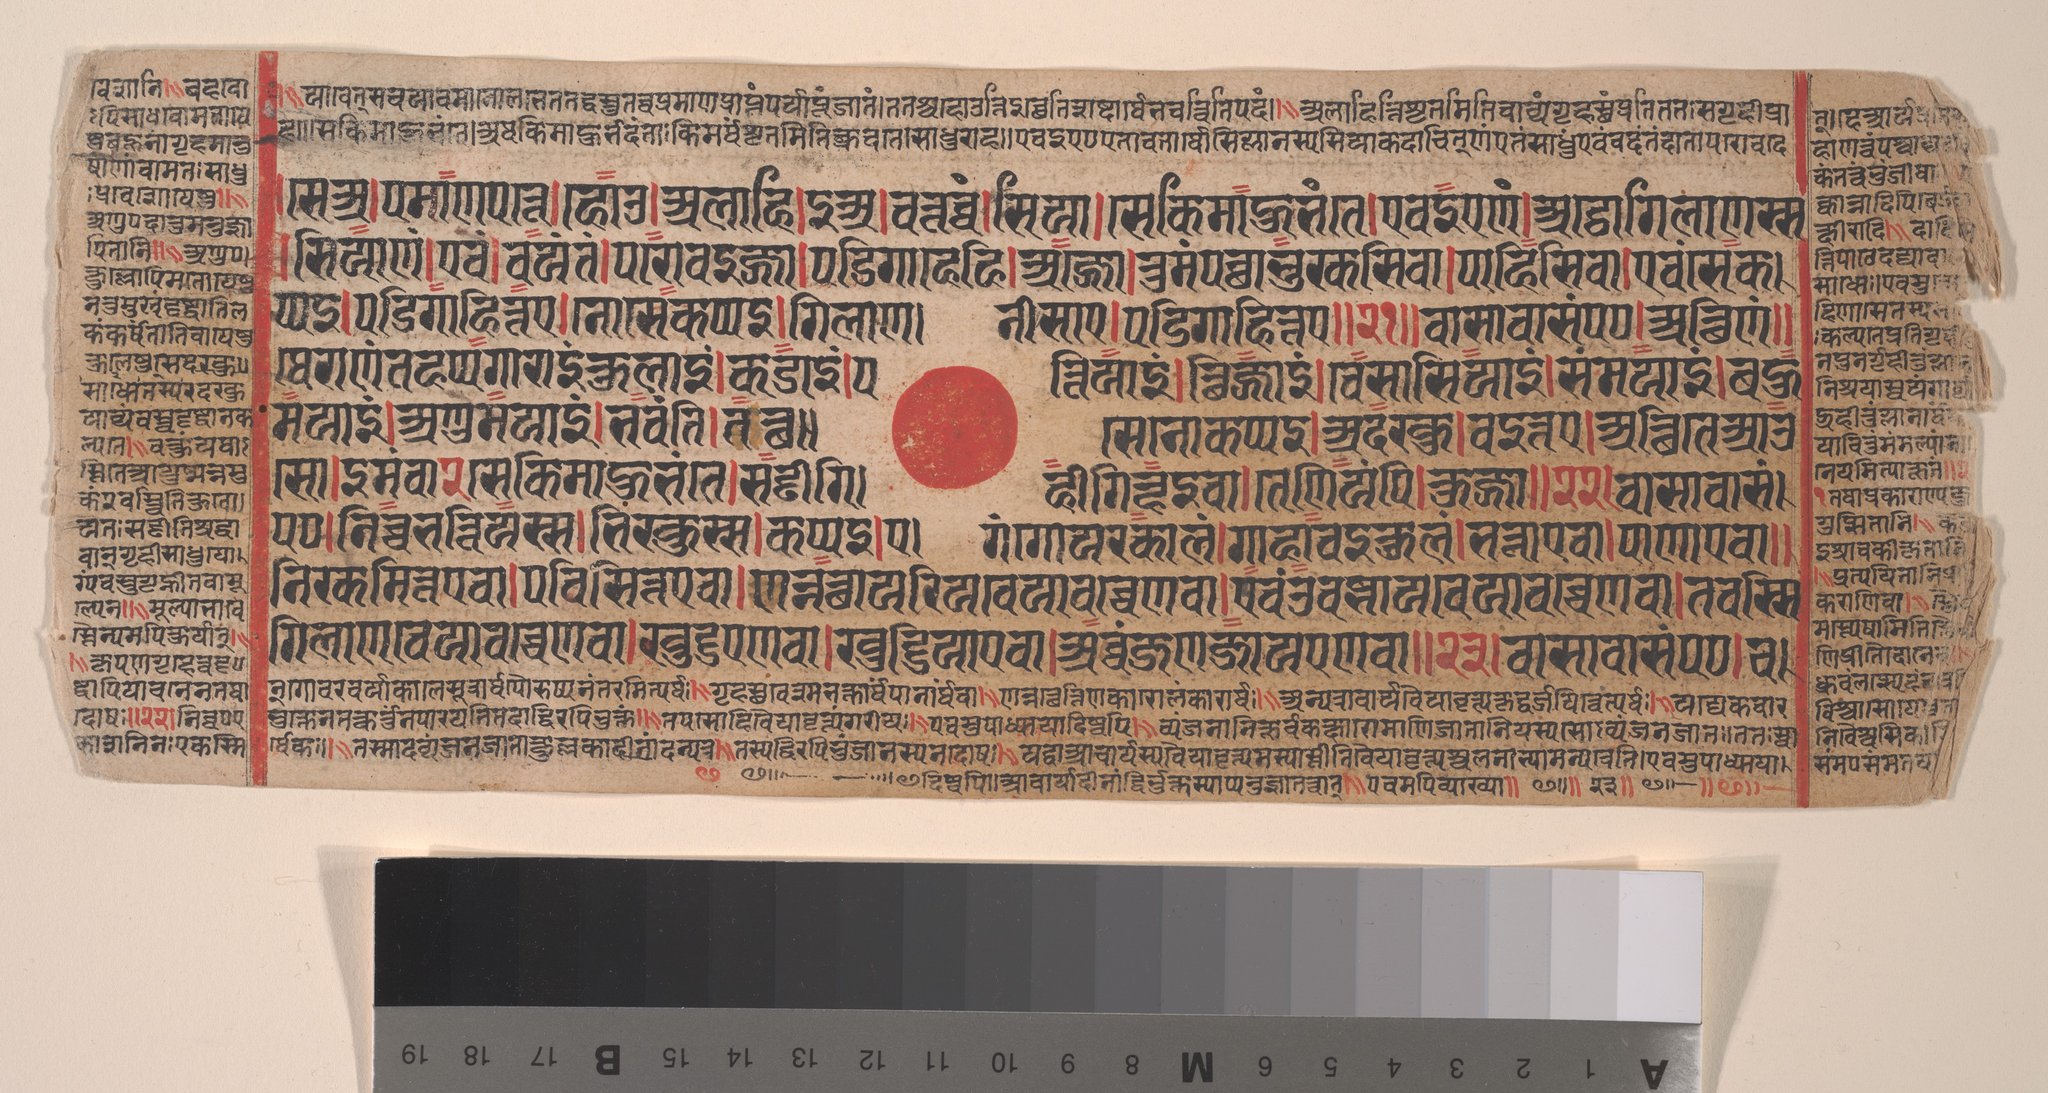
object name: folio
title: Leaf from a Kalpa Sutra (Jain Book of Rituals)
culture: indian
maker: bhadrabahu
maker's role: artist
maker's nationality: indian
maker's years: 356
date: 1401-1500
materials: gold, ink, paper, watercolor